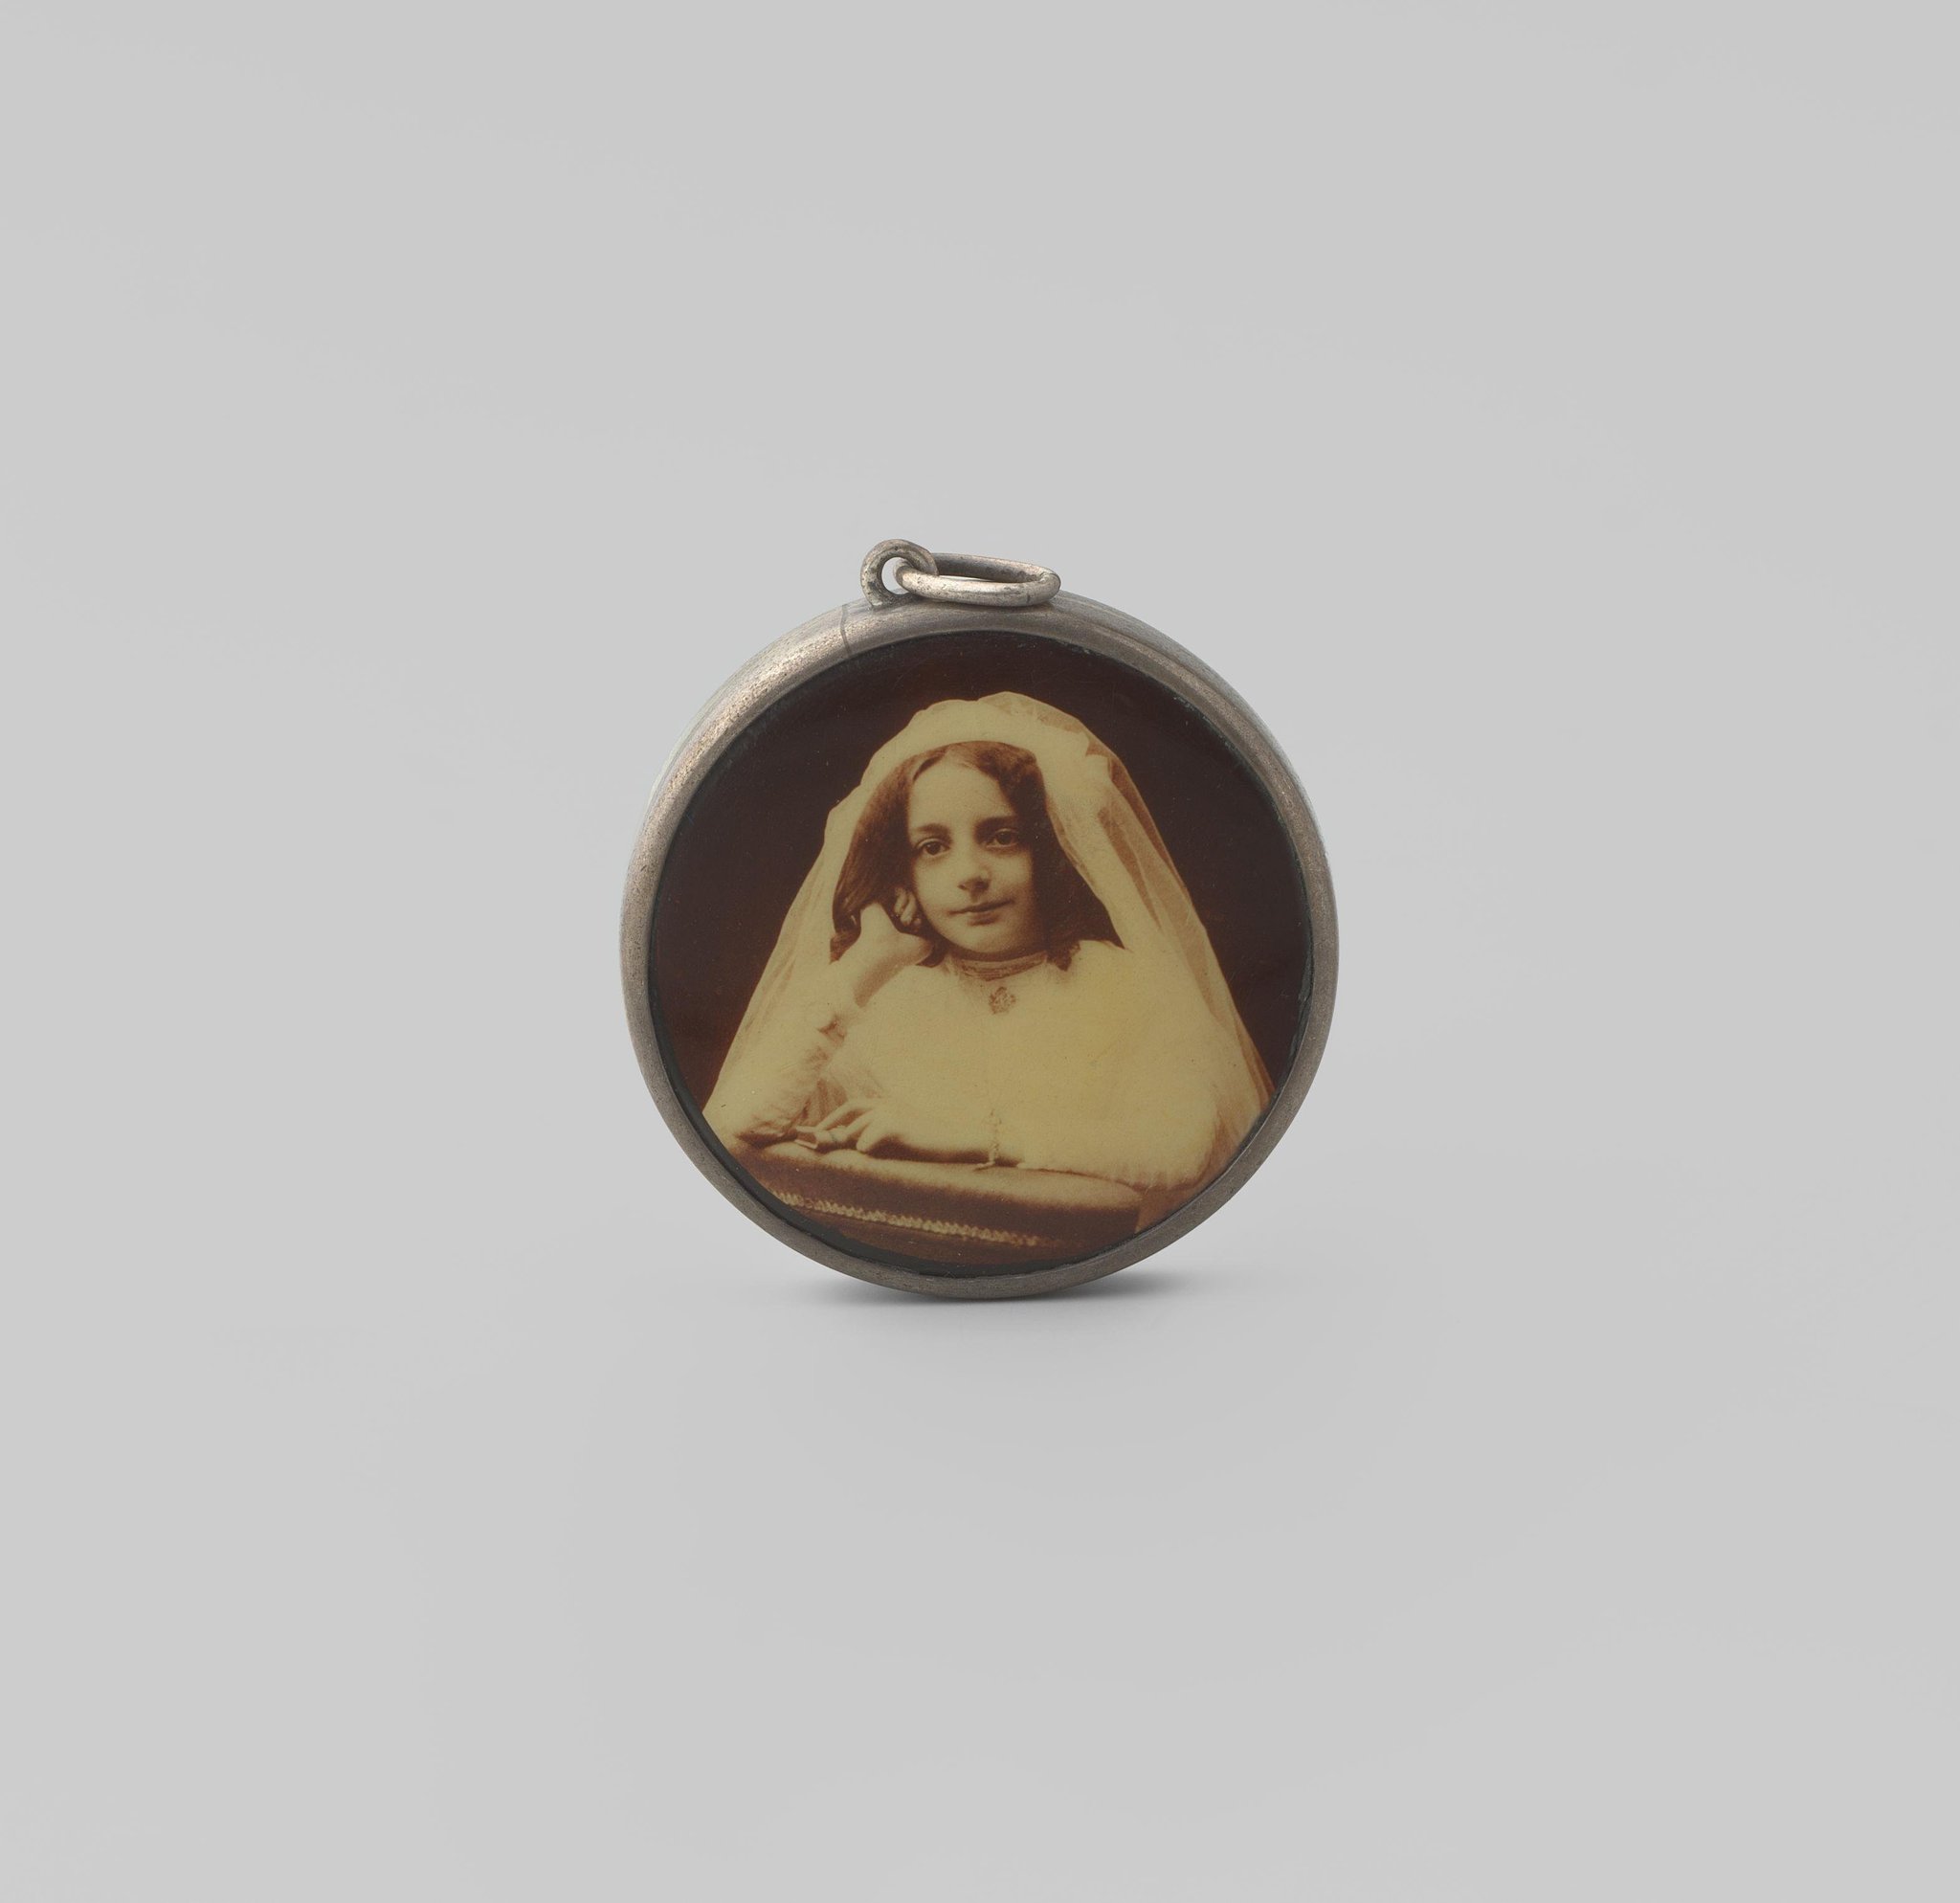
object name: pendant jewelry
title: Hanger met een portretfoto van een onbekende vrouw en een bruidsmeisje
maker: Anonymous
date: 1880-1930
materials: metal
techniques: enamel photograph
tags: bridesmaid, historical persons not known by name - bb - woman